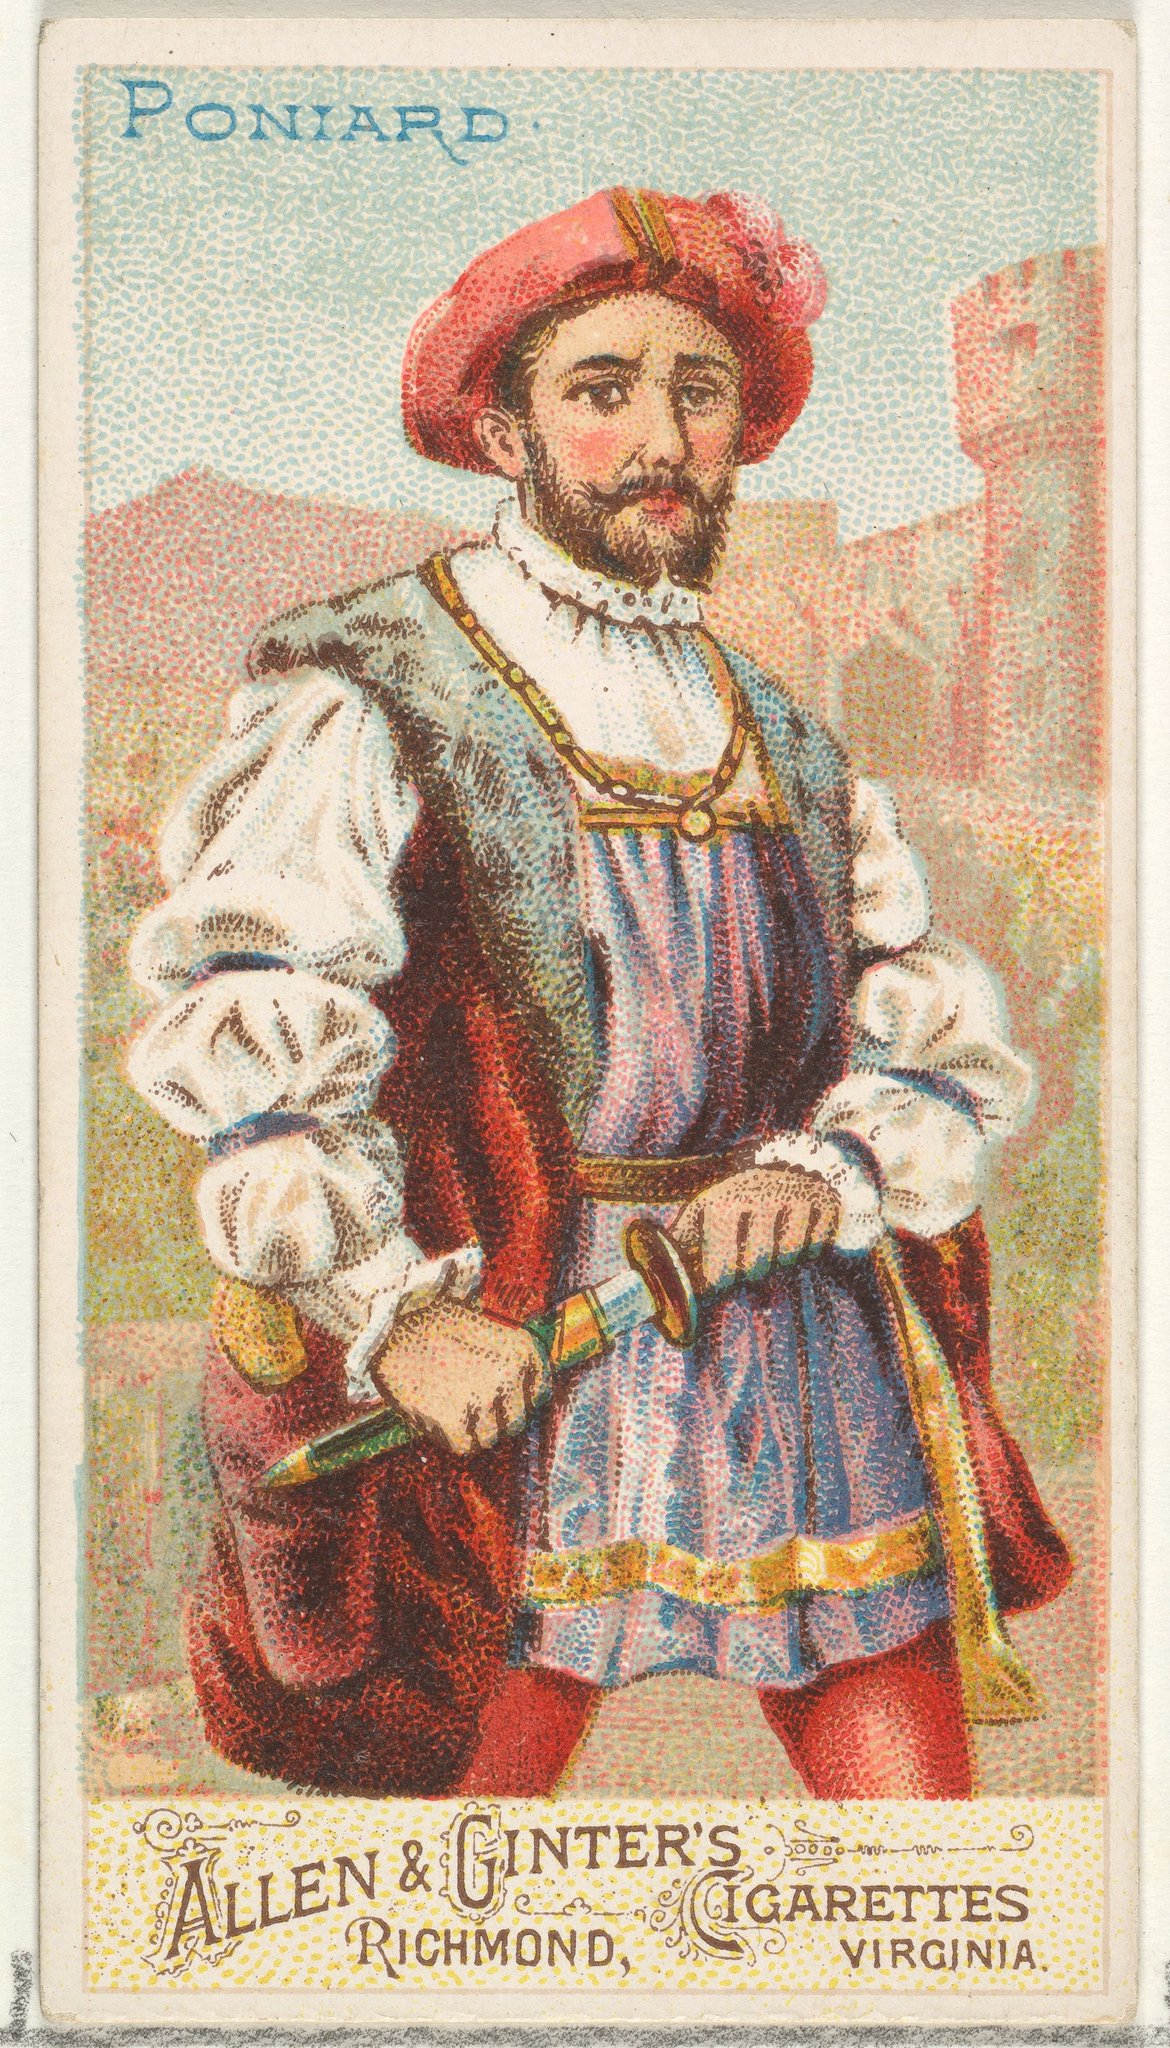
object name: print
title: Poniard, from the Arms of All Nations series (N3) for Allen & Ginter Cigarettes Brands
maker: allen & ginter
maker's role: publisher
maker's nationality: american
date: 1887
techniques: color lithograph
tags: daggers,men